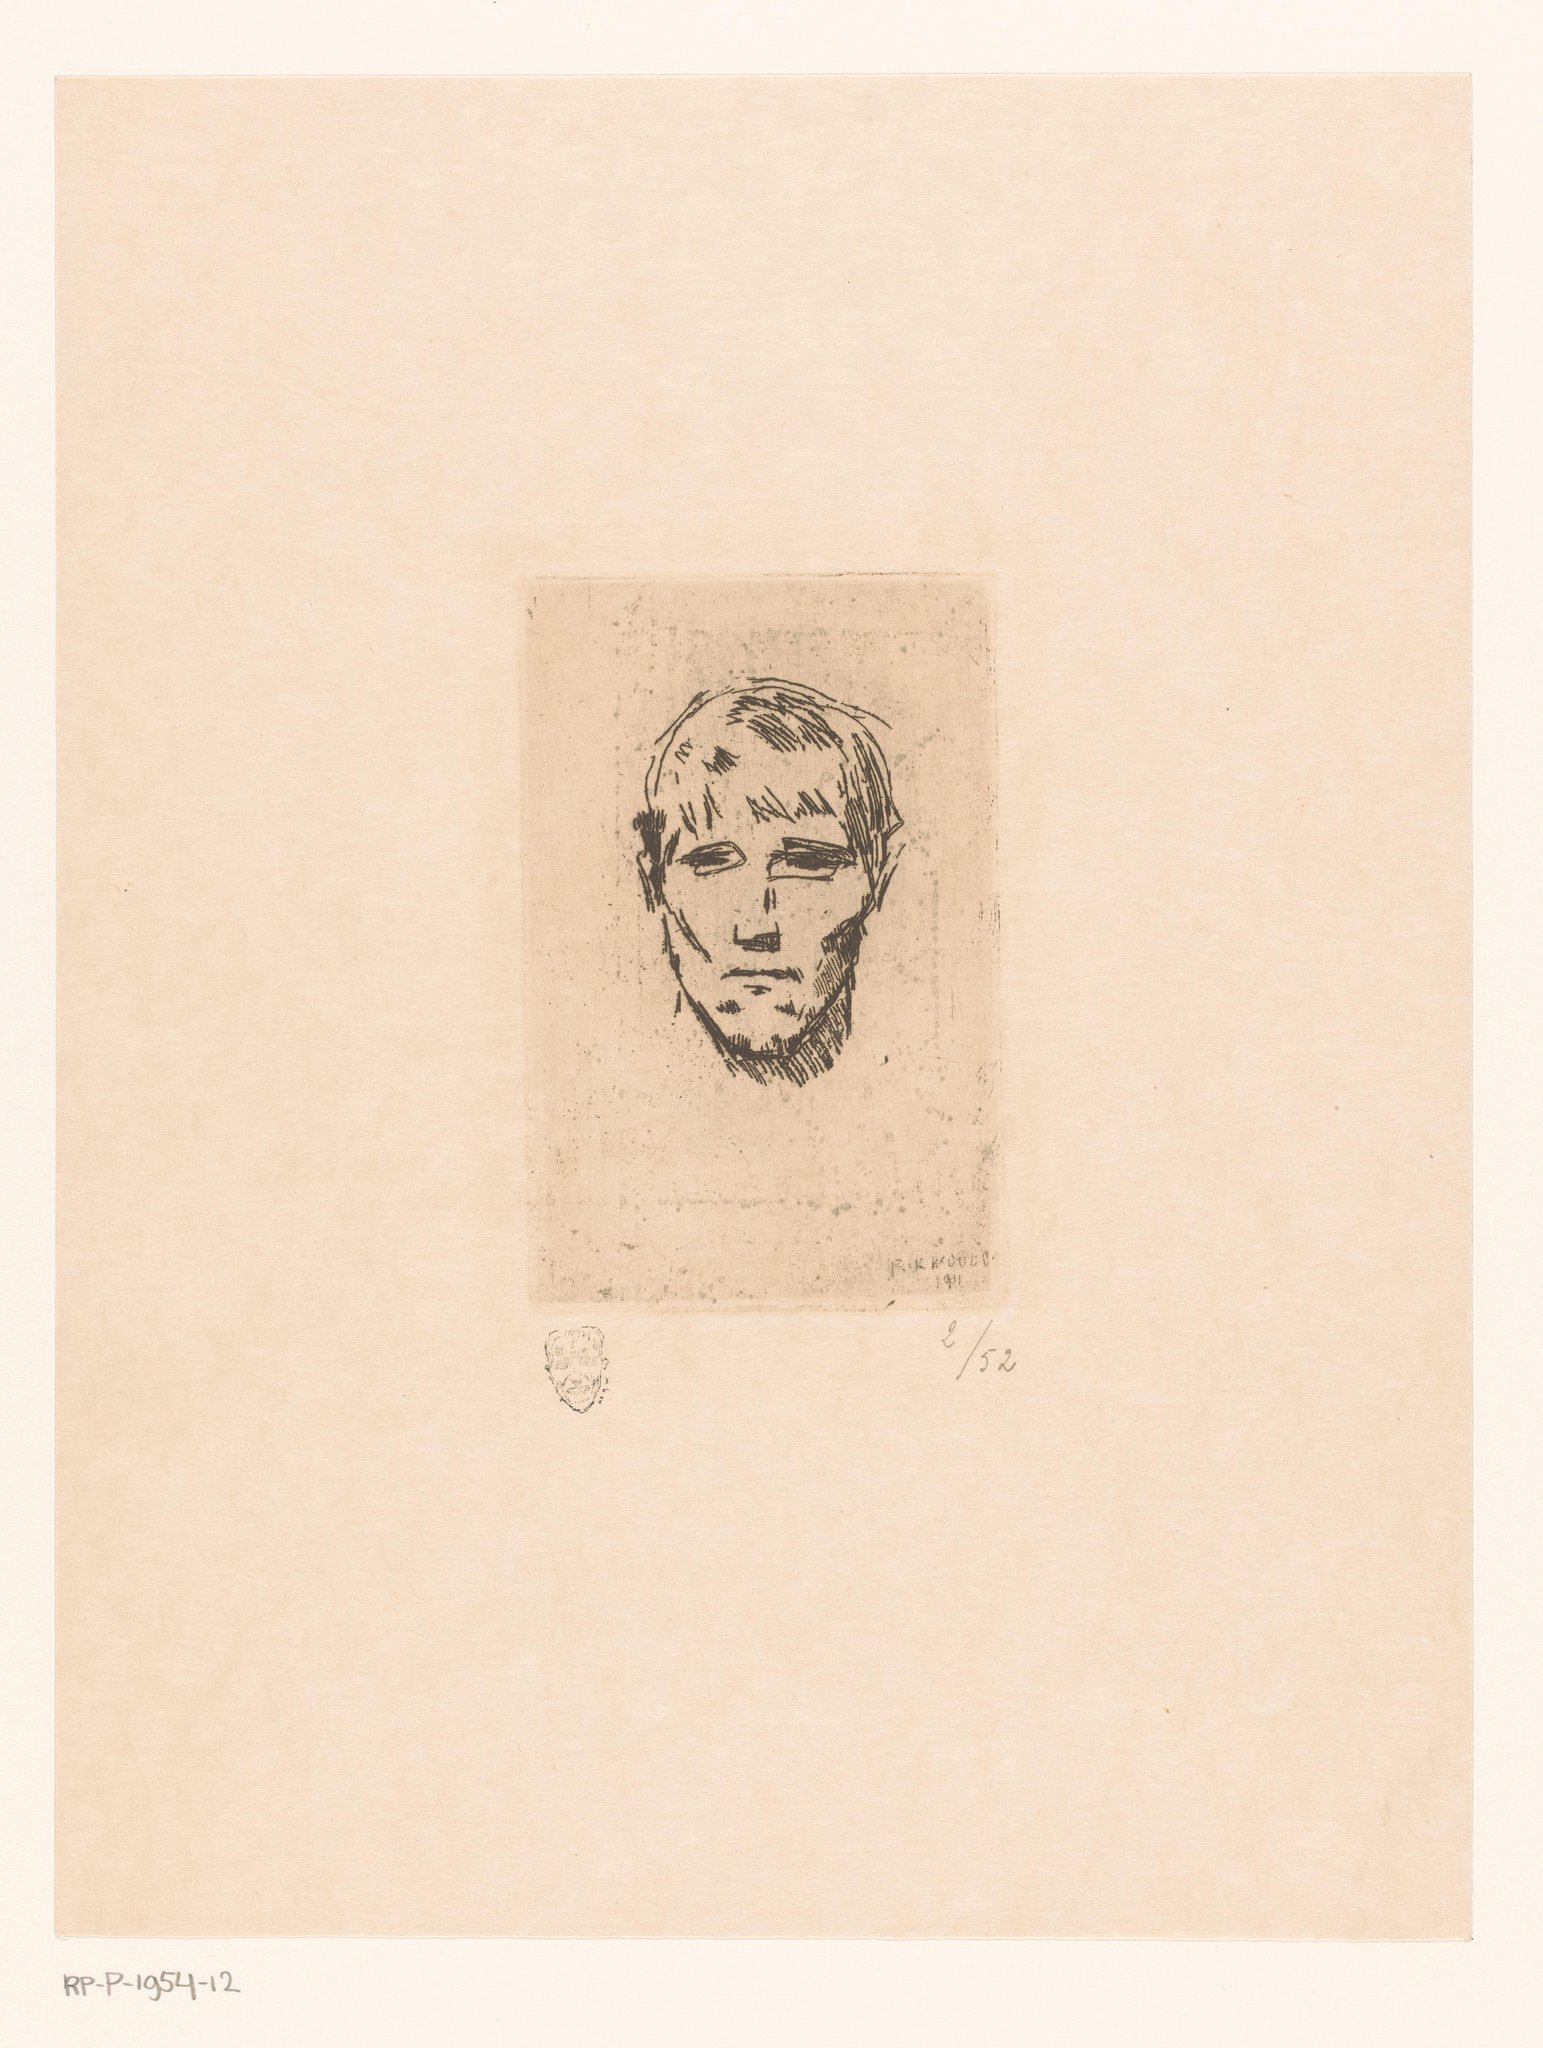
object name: print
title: Zelfportret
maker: rik wouters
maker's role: draughtsman, print maker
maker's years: 1882-1916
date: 1911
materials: paper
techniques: drypoint, intaglio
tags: mechelen, amsterdam, print maker, draughtsman, rik wouters, portrait, self-portrait of graphic artist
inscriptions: collector's mark: Lugt 2228, workshop stamp: Lugt 4195